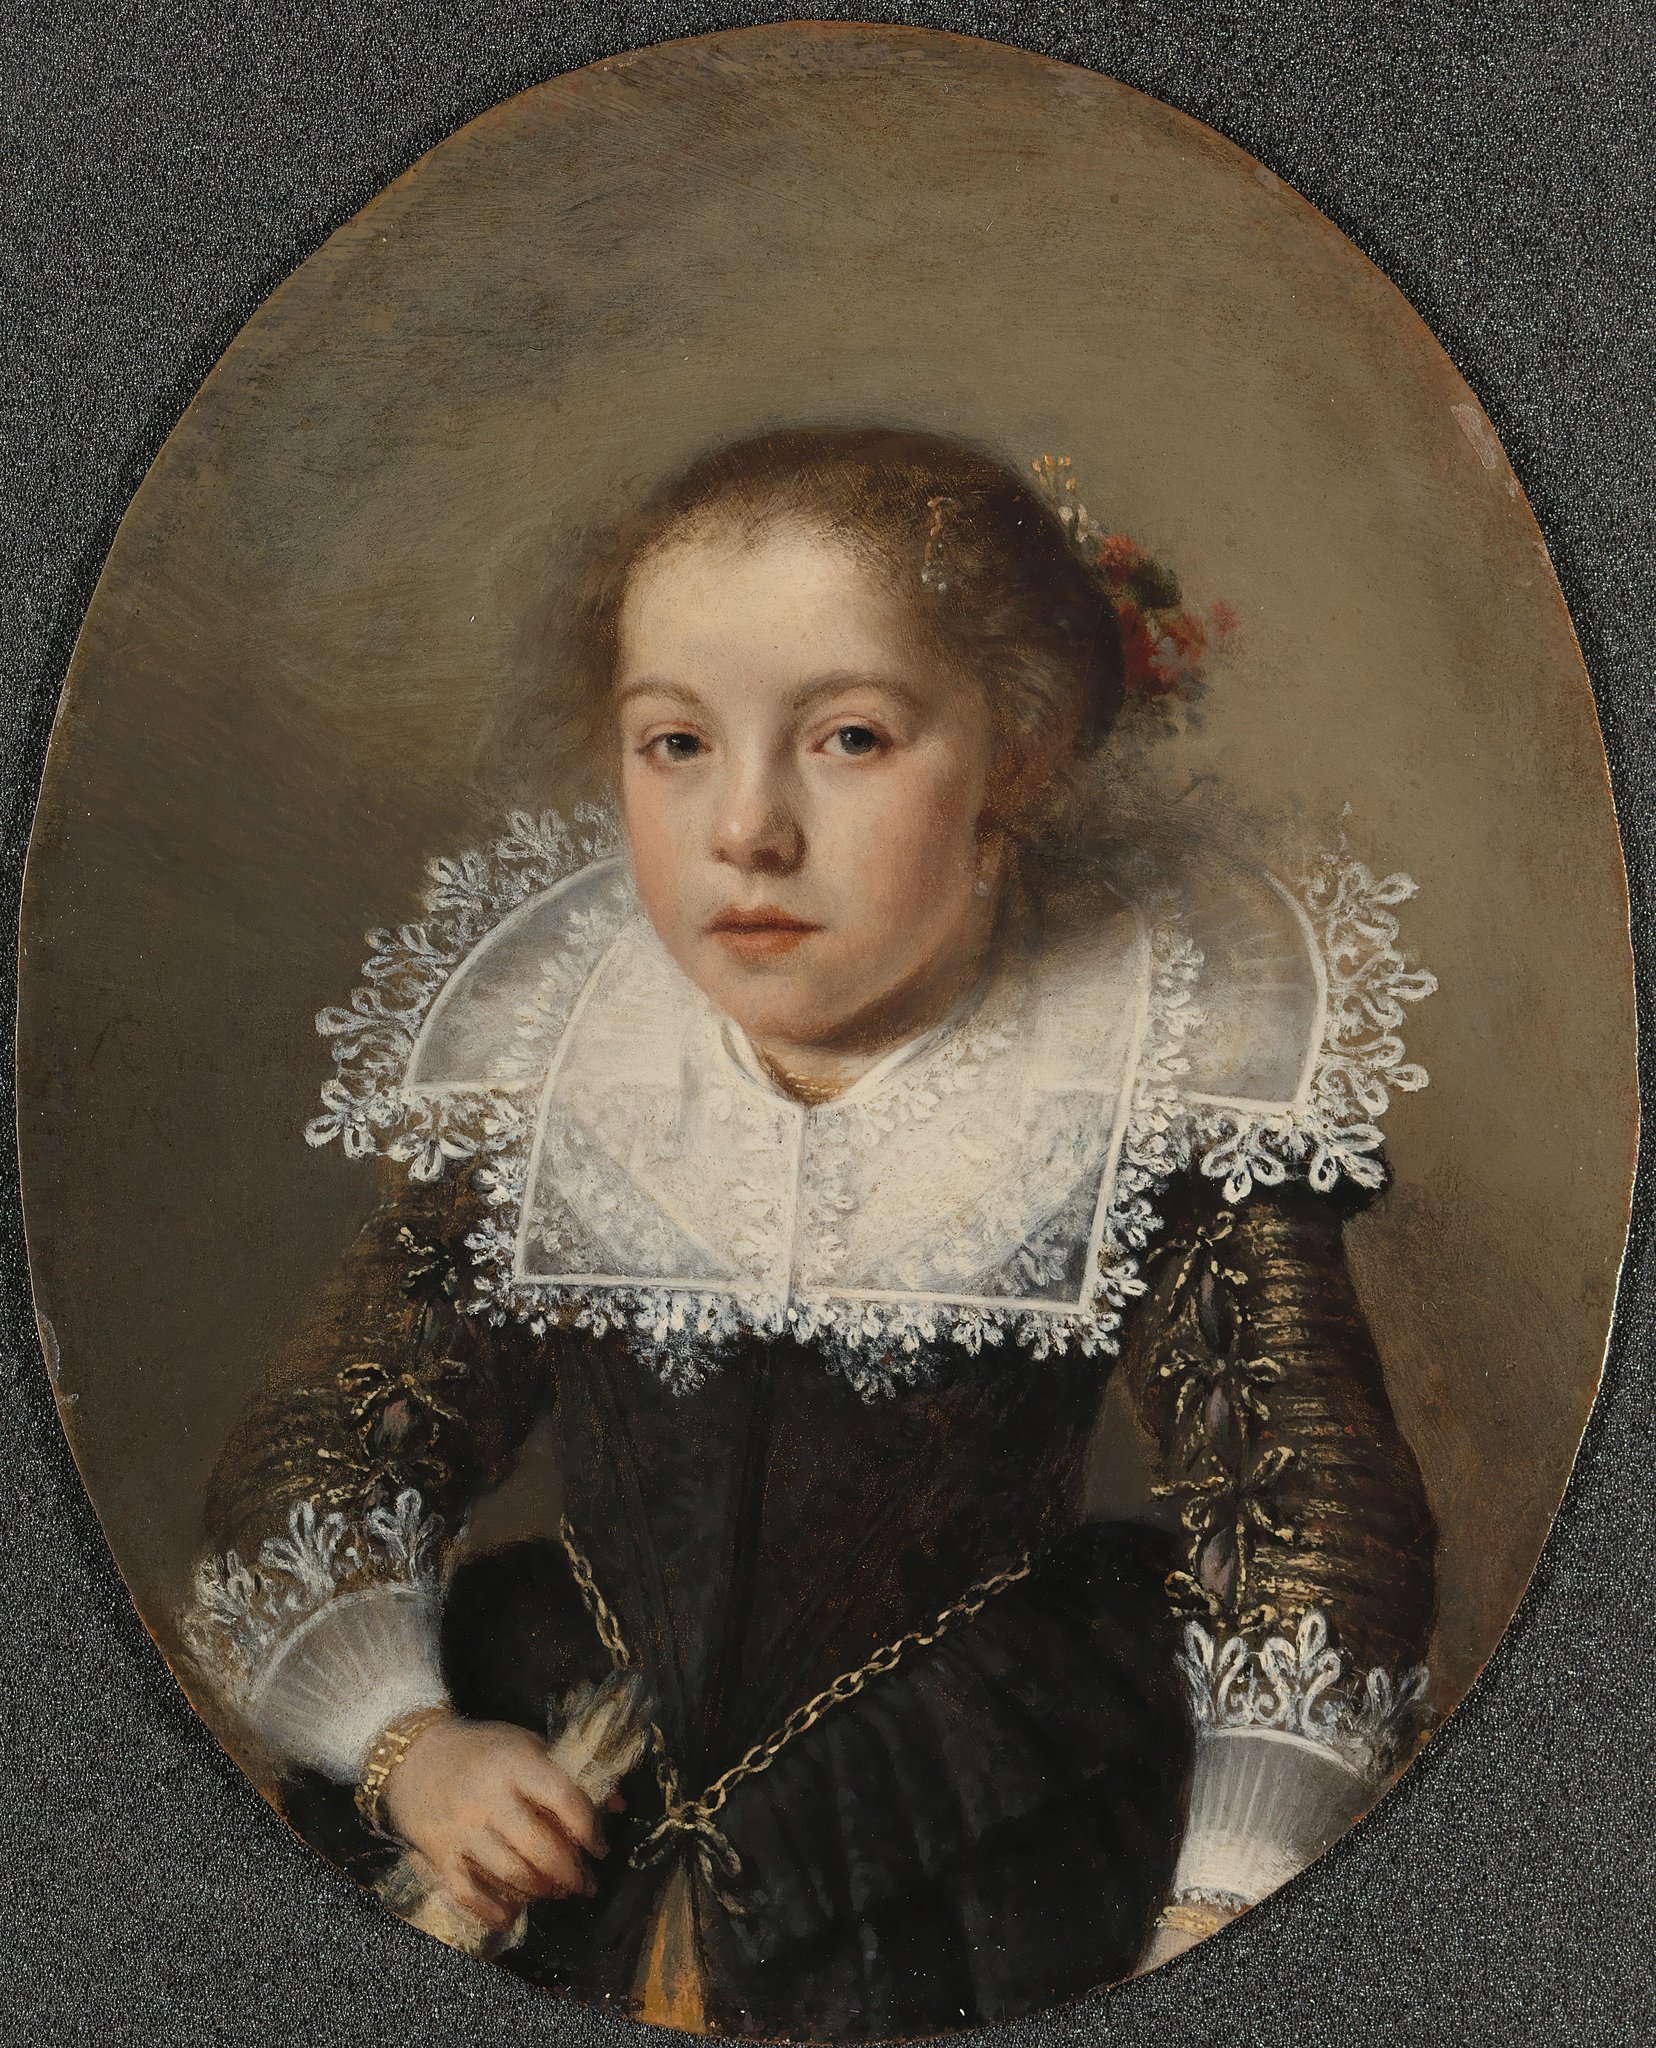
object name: painting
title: Portrait of Cornelia Cornelisdr van Esch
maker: Anonymous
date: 1632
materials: copper, oil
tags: dordrecht, historical persons - bb - woman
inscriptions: inscription and date, centre left: ‘ÆTA.s [...] 1632’, inscription, on the reverse: ‘Miereveldt’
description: Portret van Cornelia, dochter van Cornelis Samuelsz. van Esch en Josina Jansdr. de Carpentier. Ten halven lijve, iets naar links. Onderdeel van een serie van zeven ovale portretten van Cornelis Samuelsz van Esch, zijn vrouw Josina Jansdr de Carpentier, hun drie dochtertjes en twee zoontjes (SK-A-1747-A/G).